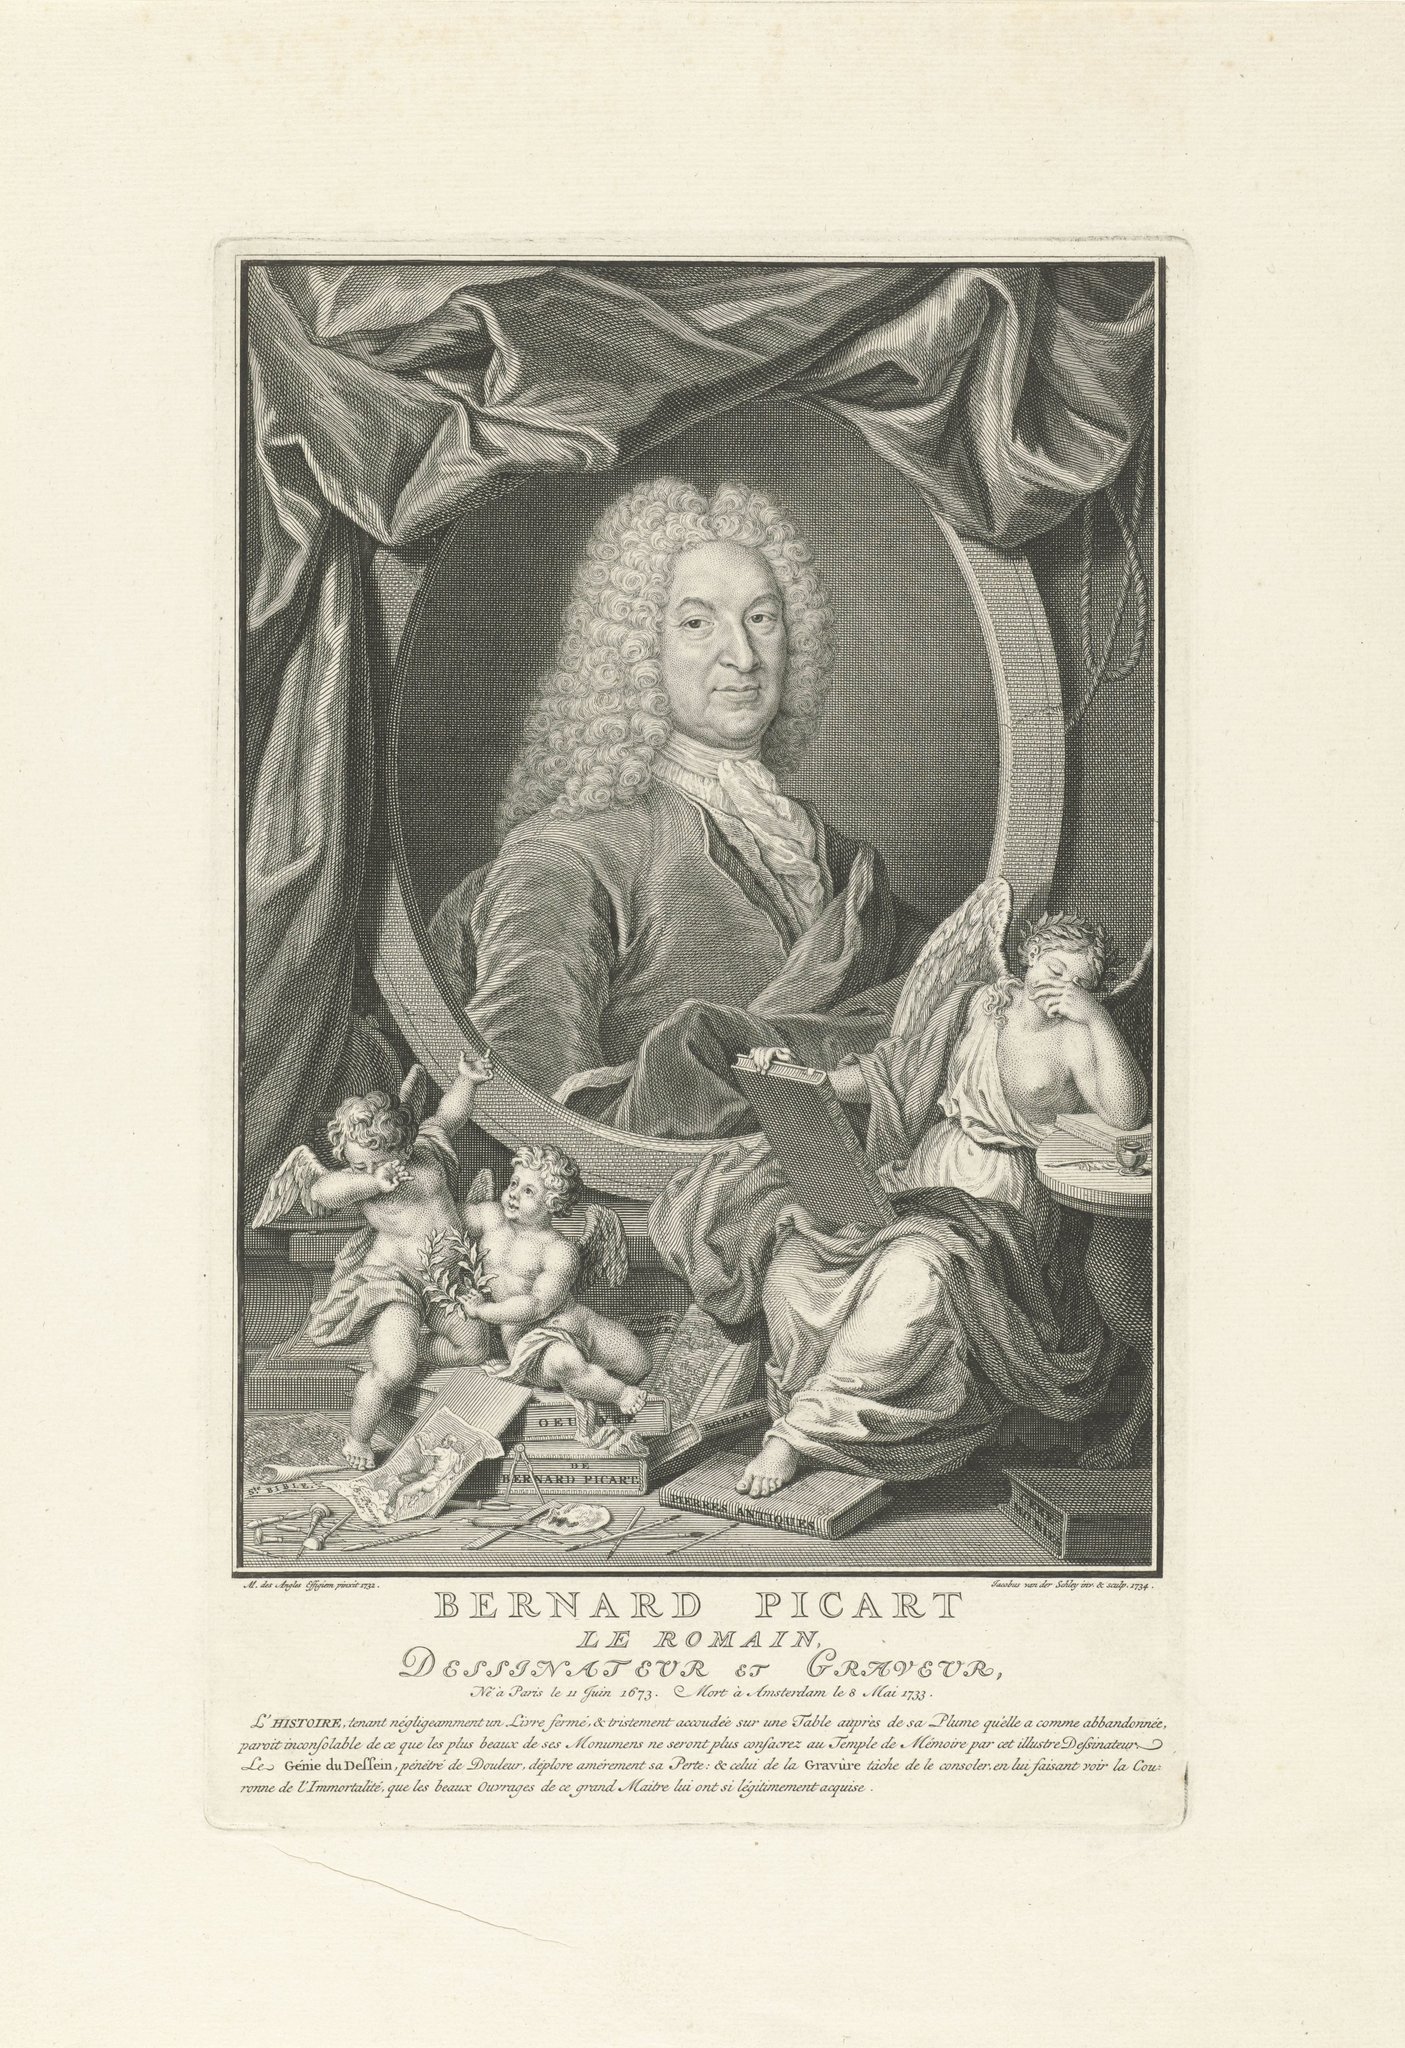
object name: print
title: Portret van Bernard Picart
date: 1734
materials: paper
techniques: engraving, etching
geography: amsterdam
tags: paris, amsterdam, print maker, draughtsman, publisher, bernard picart, tools, implements of craftsman (+ engraving, etching), historical persons, brushes ~ implements of painter, mourning the dead, cupids: 'amores', 'amoretti', 'putti'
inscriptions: collector's mark: Lugt 240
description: Portret van de graveur, tekenaar en schilder Bernard Picart. Voor het portret treuren twee putti en zit een personificatie van Geschiedenis. Op de grond liggen boeken, prenten en schilder- en graveergereedschap. In de marge zijn naam, geboorte- en sterfjaar en een rouwtekst met lovende woorden over de tekeningen en prenten die Picart heeft nagelaten.